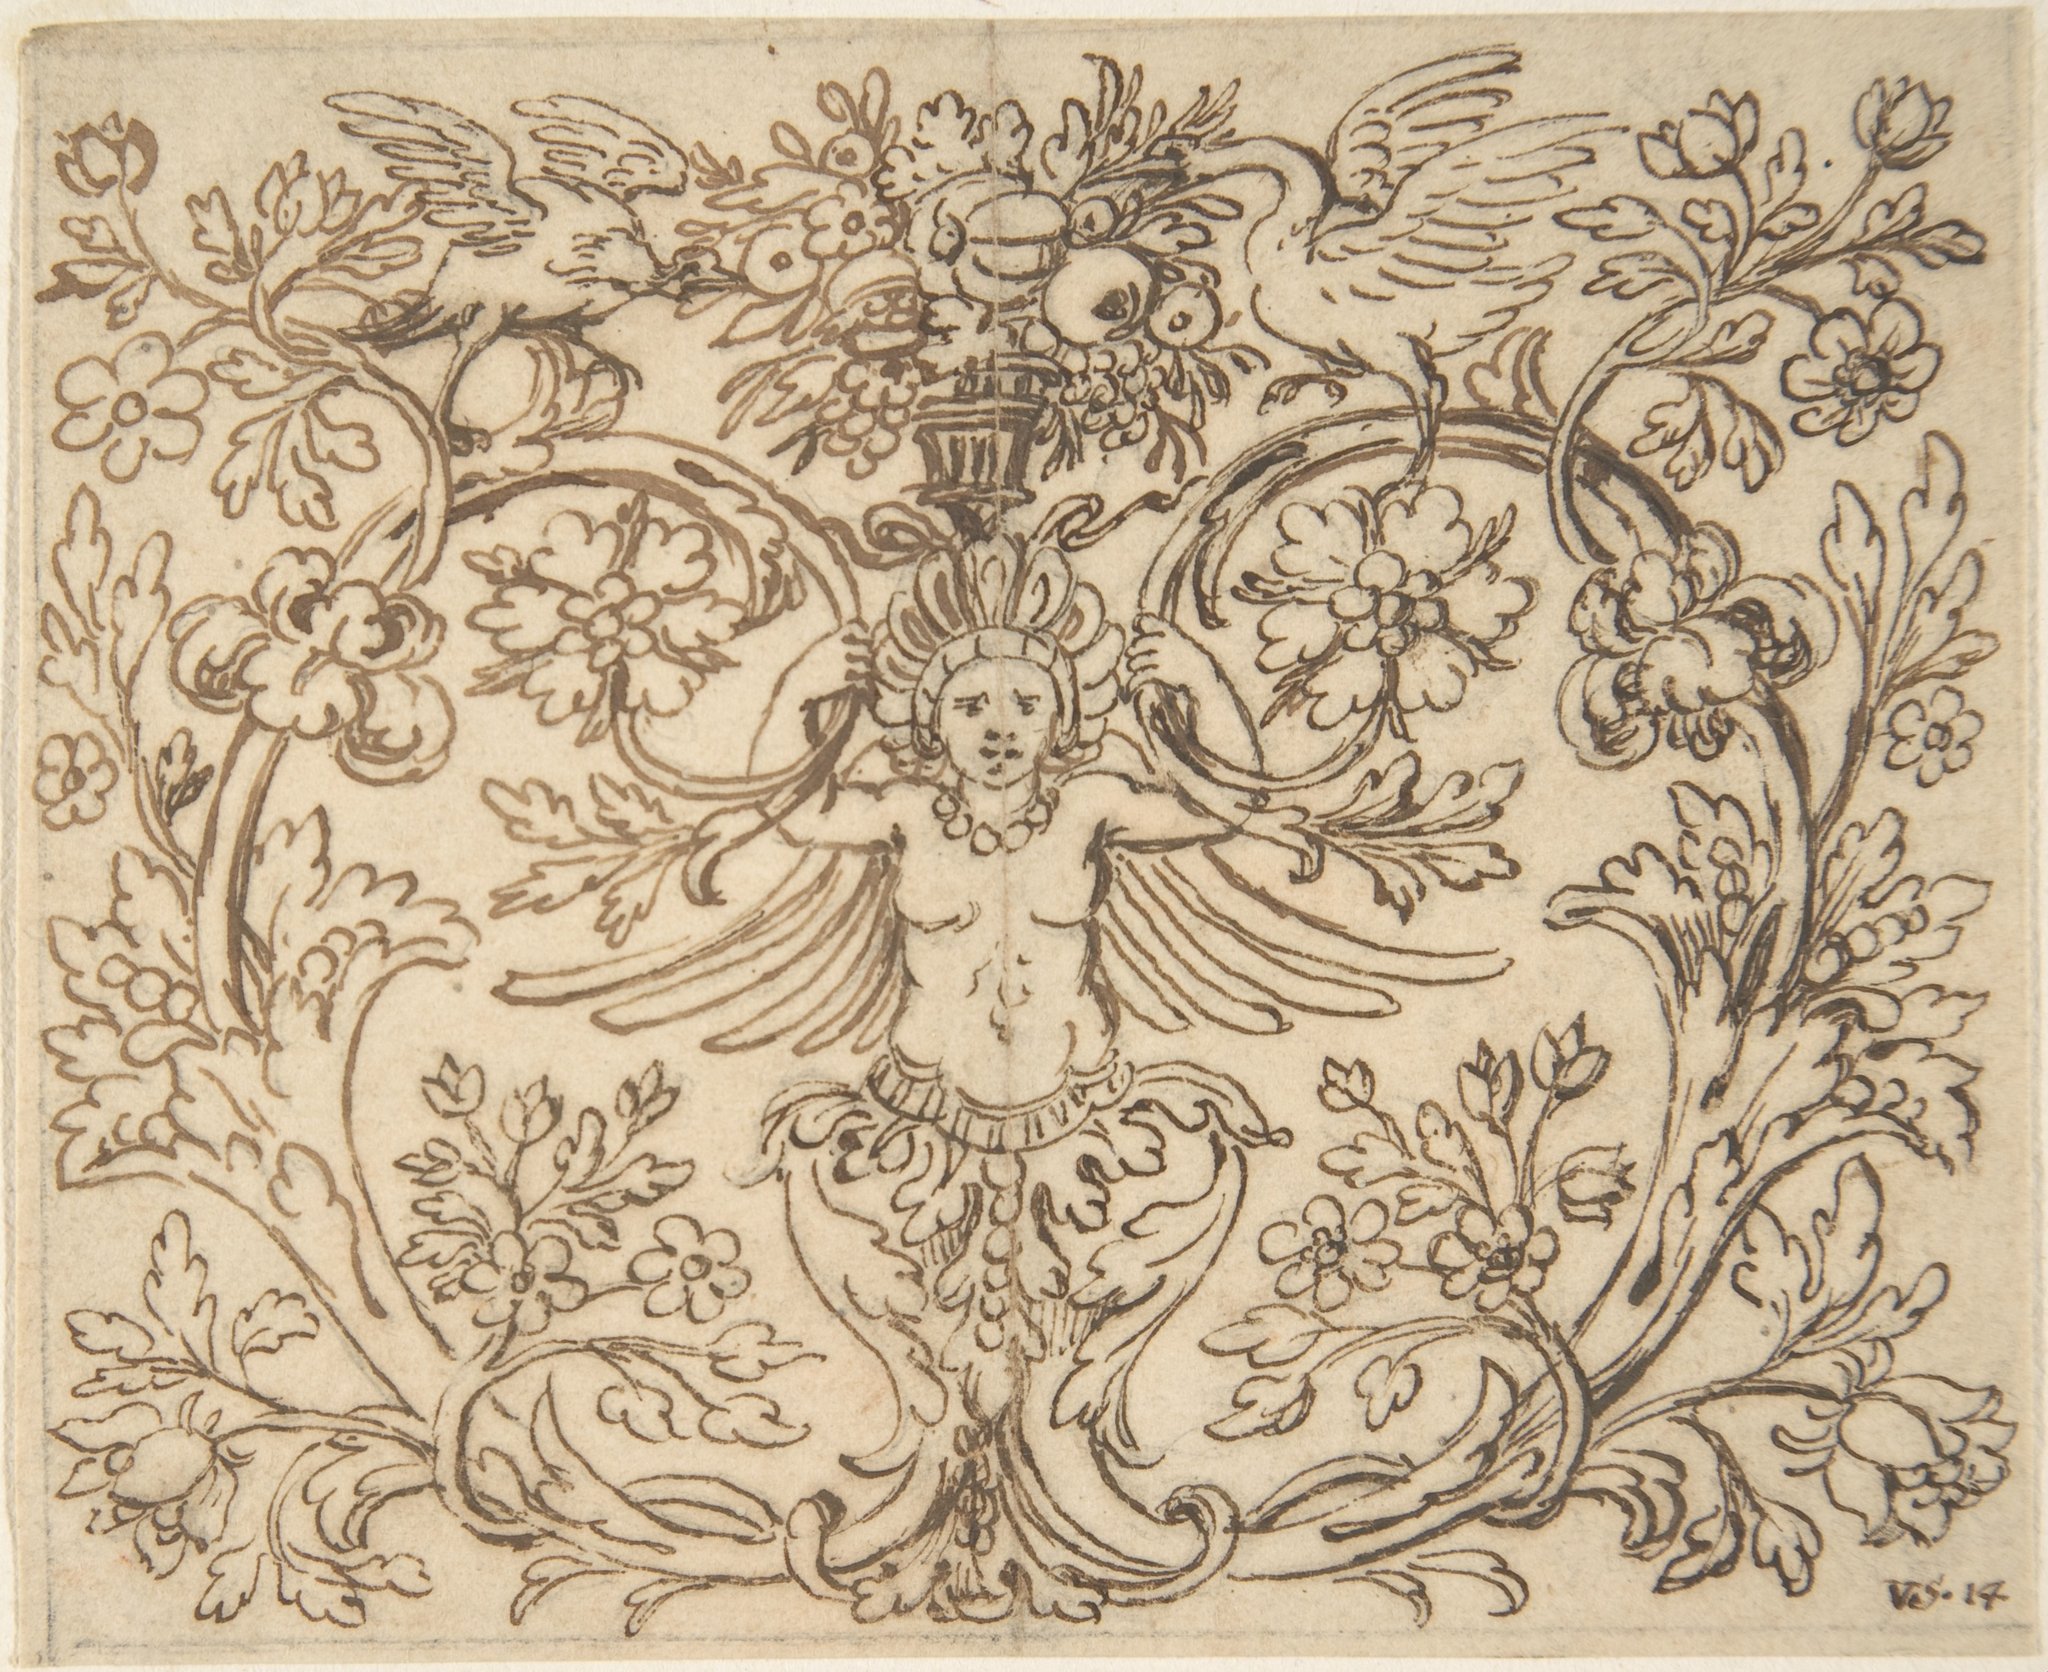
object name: drawing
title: Design for a Decroative Panel with a Hybrid Figure from which Two Tendrils Emerge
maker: anonymous, italian, 16th to 17th century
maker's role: artist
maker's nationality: italian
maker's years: 1500-1700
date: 1500-1700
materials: chalk, ink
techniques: pen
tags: birds,flowers